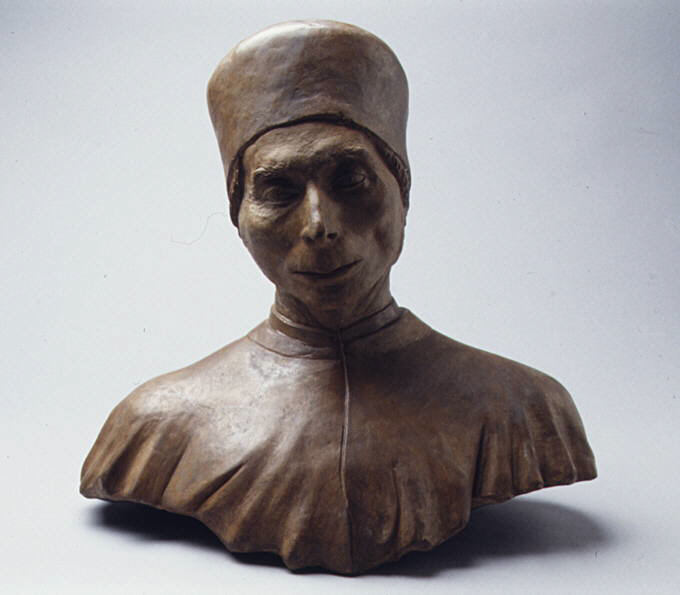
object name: bust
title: Raffaello Maffei (1456–1522)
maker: silvio cosini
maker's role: artist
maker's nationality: italian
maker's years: 1495-1549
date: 1529-1532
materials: terracotta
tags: men,portraits